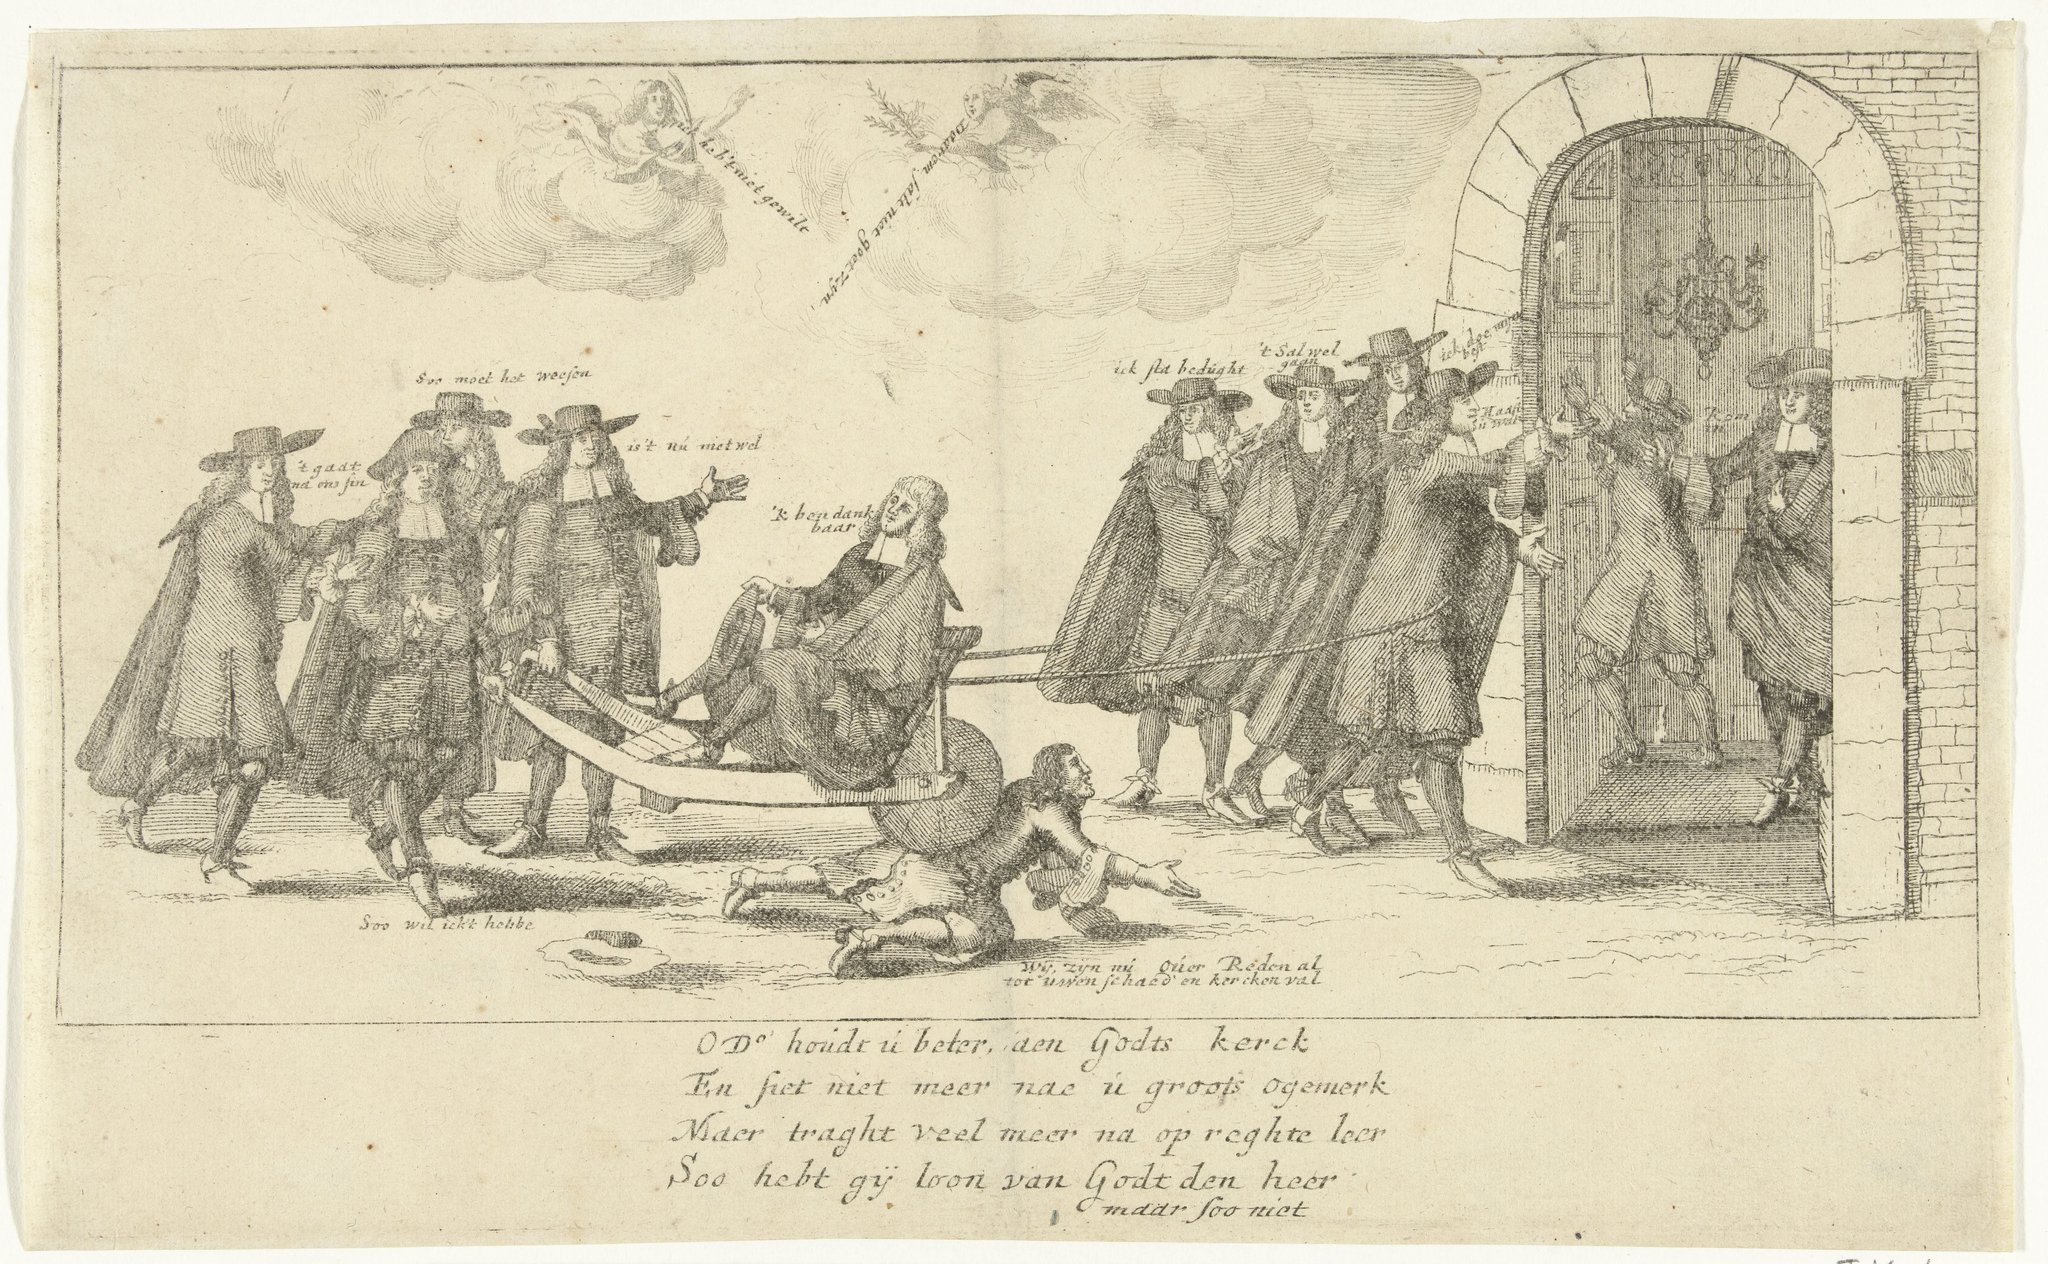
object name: cartoon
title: Theodorus Dominicus wordt op een kruiwagen de kerk ingereden, 1683-1684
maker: Anonymous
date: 1683-1684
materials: paper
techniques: etching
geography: northern netherlands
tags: amsterdam, wheelbarrow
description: Spotprent op de lutherse kerktwisten te Amsterdam tussen de Hollandse (vrijzinnig) en de Duitse (rechtzinnig) richting binnen de lutherse gemeente en die een hoogtepunt bereiken in de strijd rond de aanstelling van de predikant Theodorus Dominicus te Amsterdam in 1683. Dominicus zittend op een kruiwagen wordt door twee groepen van 4 man getrokken en geduwd in de richting van een openstaande kerkdeur. De kruiwagen rijdt over een man (de Gemeente) die het uitschreeuwt. In de wolken twee engelen. Onder de voorstelling een vers van 4 regels. Bij de prent behoren twee tekstbladen met verzen.